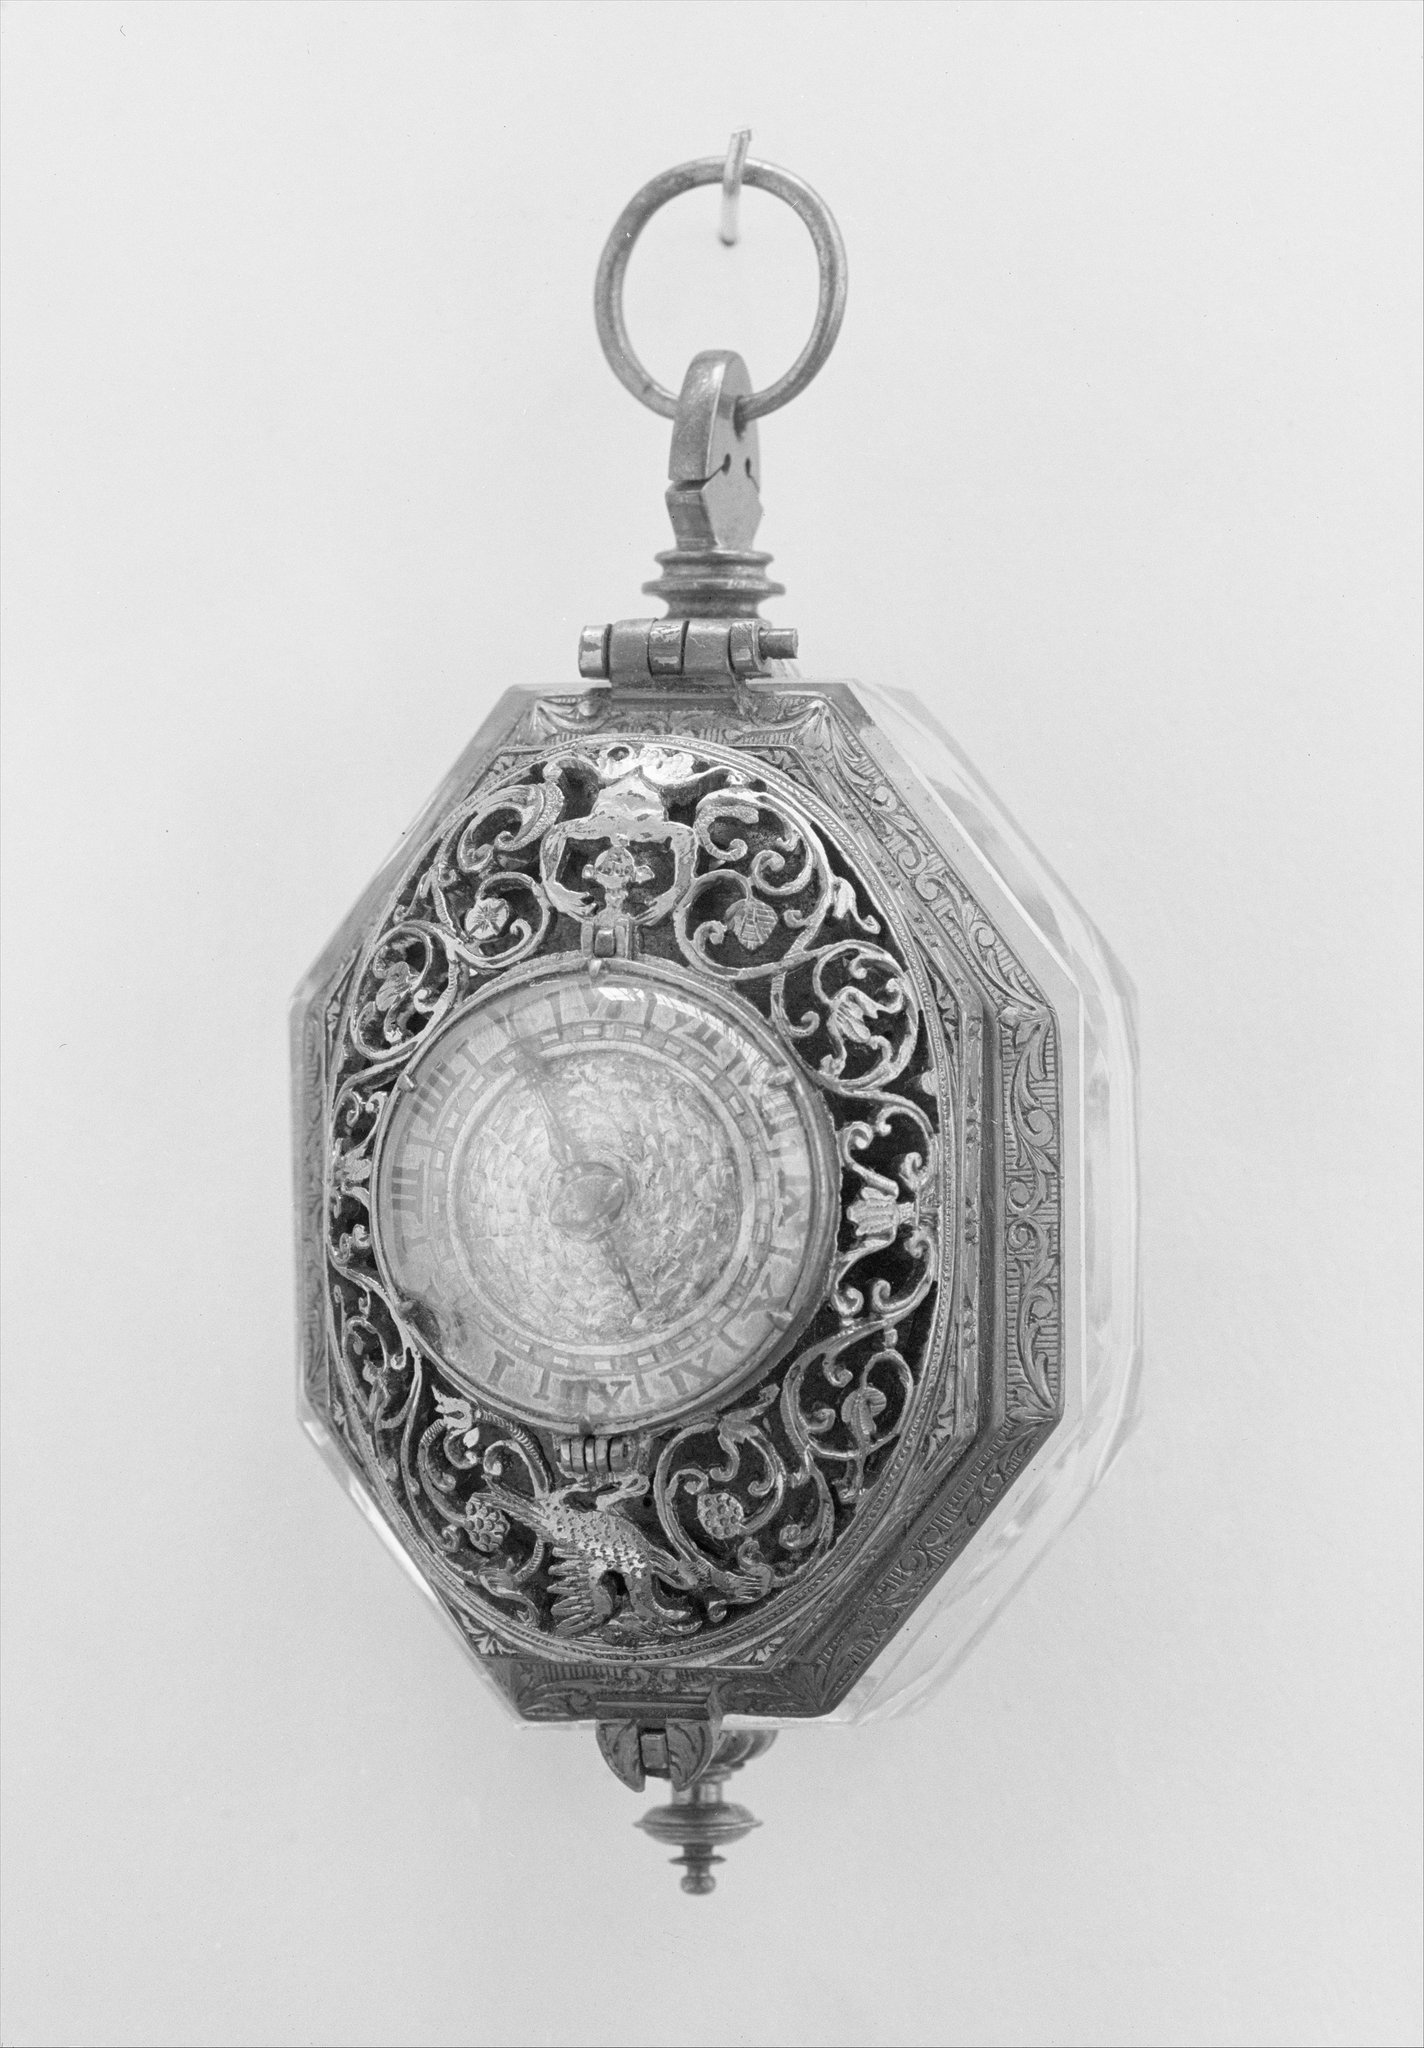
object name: watch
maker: timothée hubert (the elder)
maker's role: maker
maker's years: 1600-1650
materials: enamel, gilt, metal, quartz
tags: birds